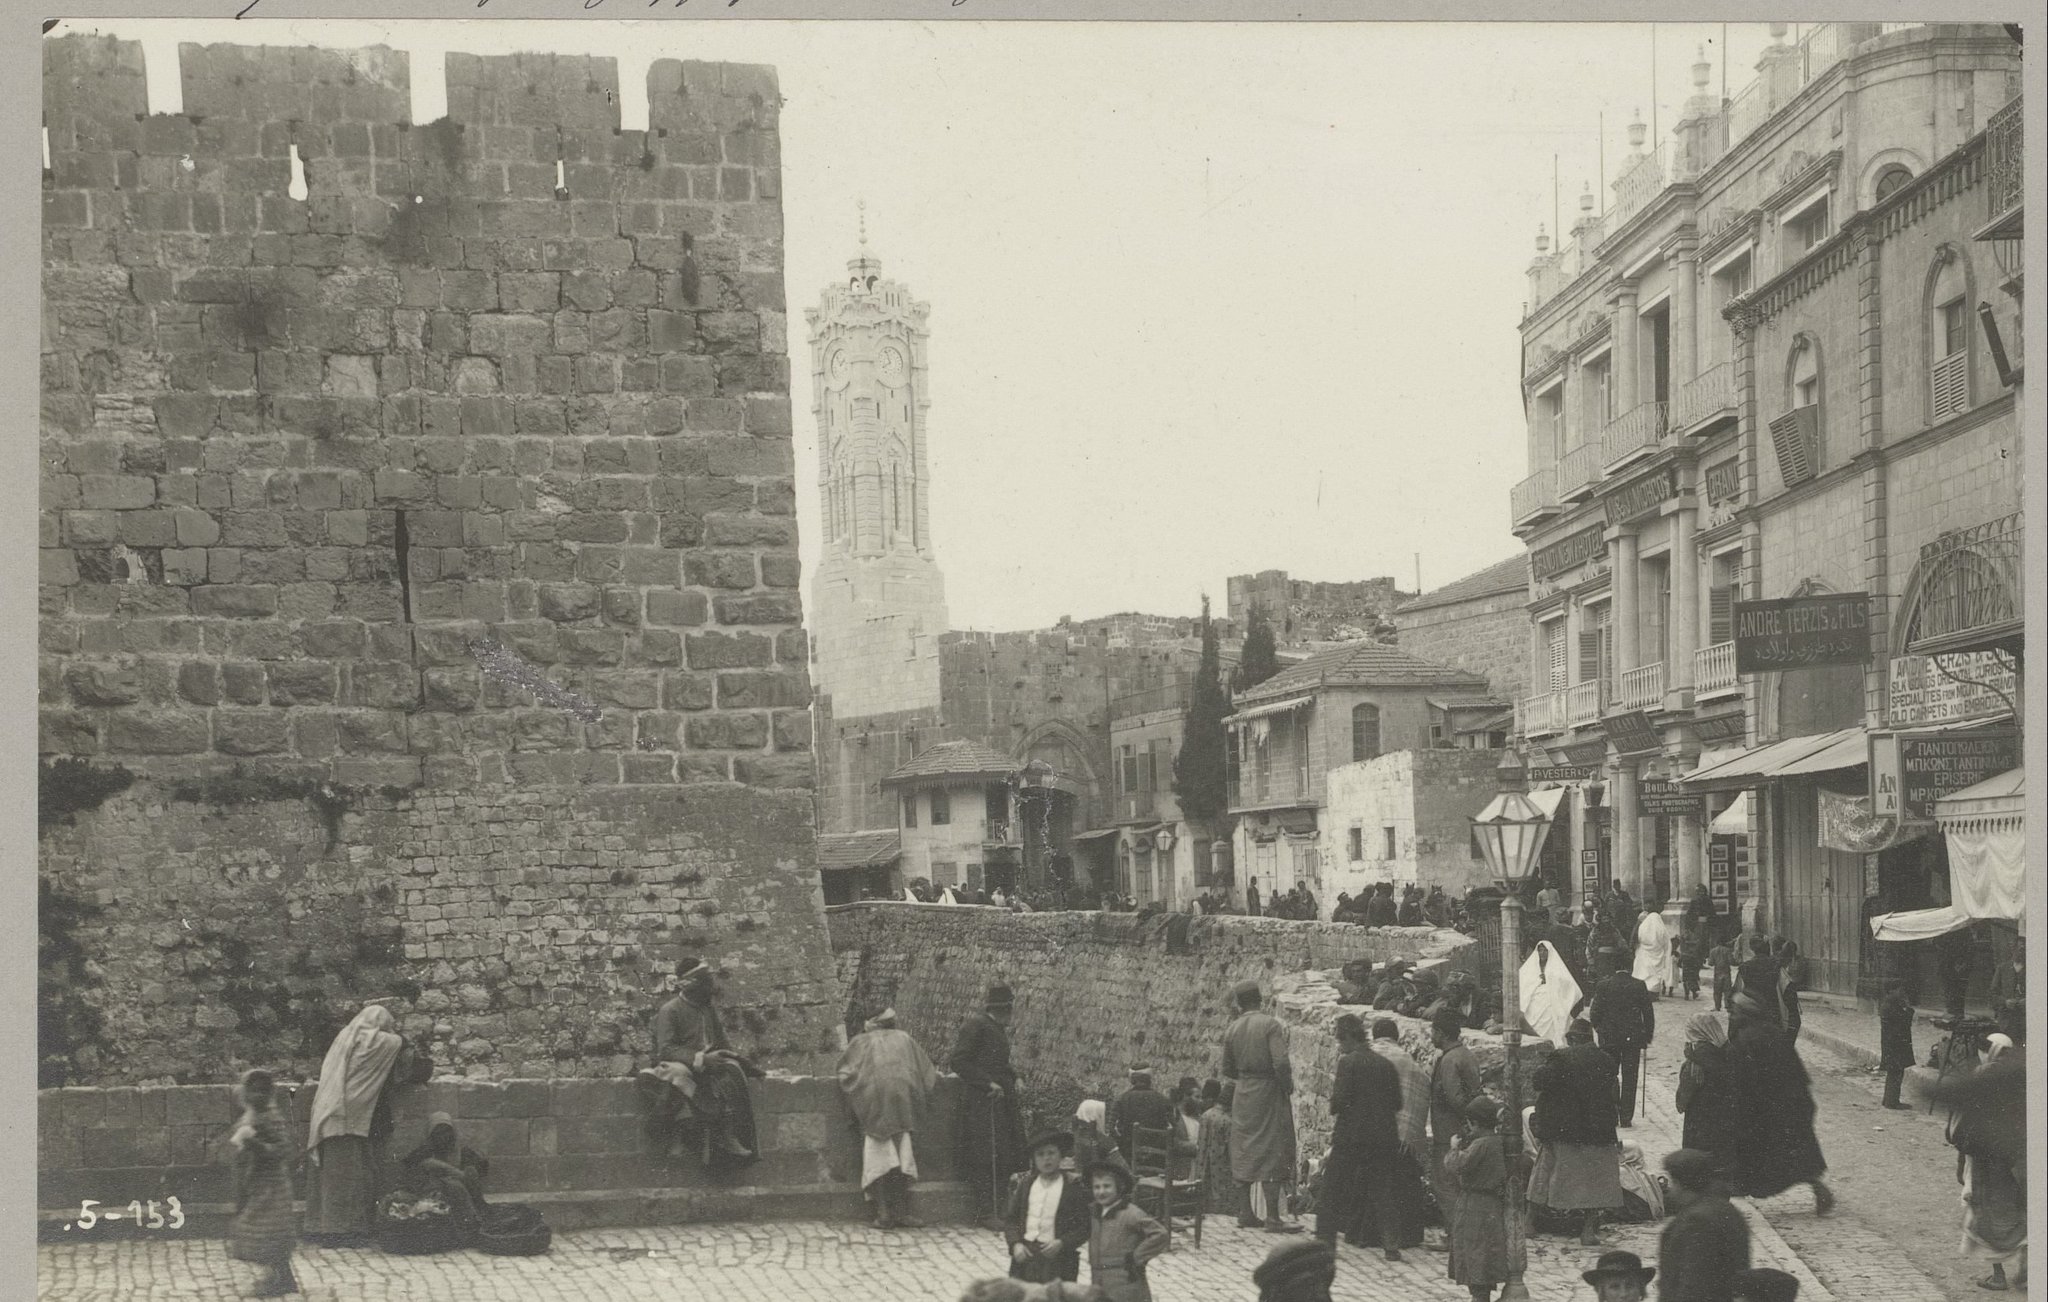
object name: photograph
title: Straatgezicht bij de Jaffapoort in Jeruzalem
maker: Anonymous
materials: photographic support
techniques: gelatin silver print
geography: jerusalem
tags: gate, entrance, city-gate, street (+ city(-scape) with figures, staffage)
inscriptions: number: ‘5-153’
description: Onderdeel van Fotoalbum van een reis door Zuid-Europa en het Midden-Oosten.